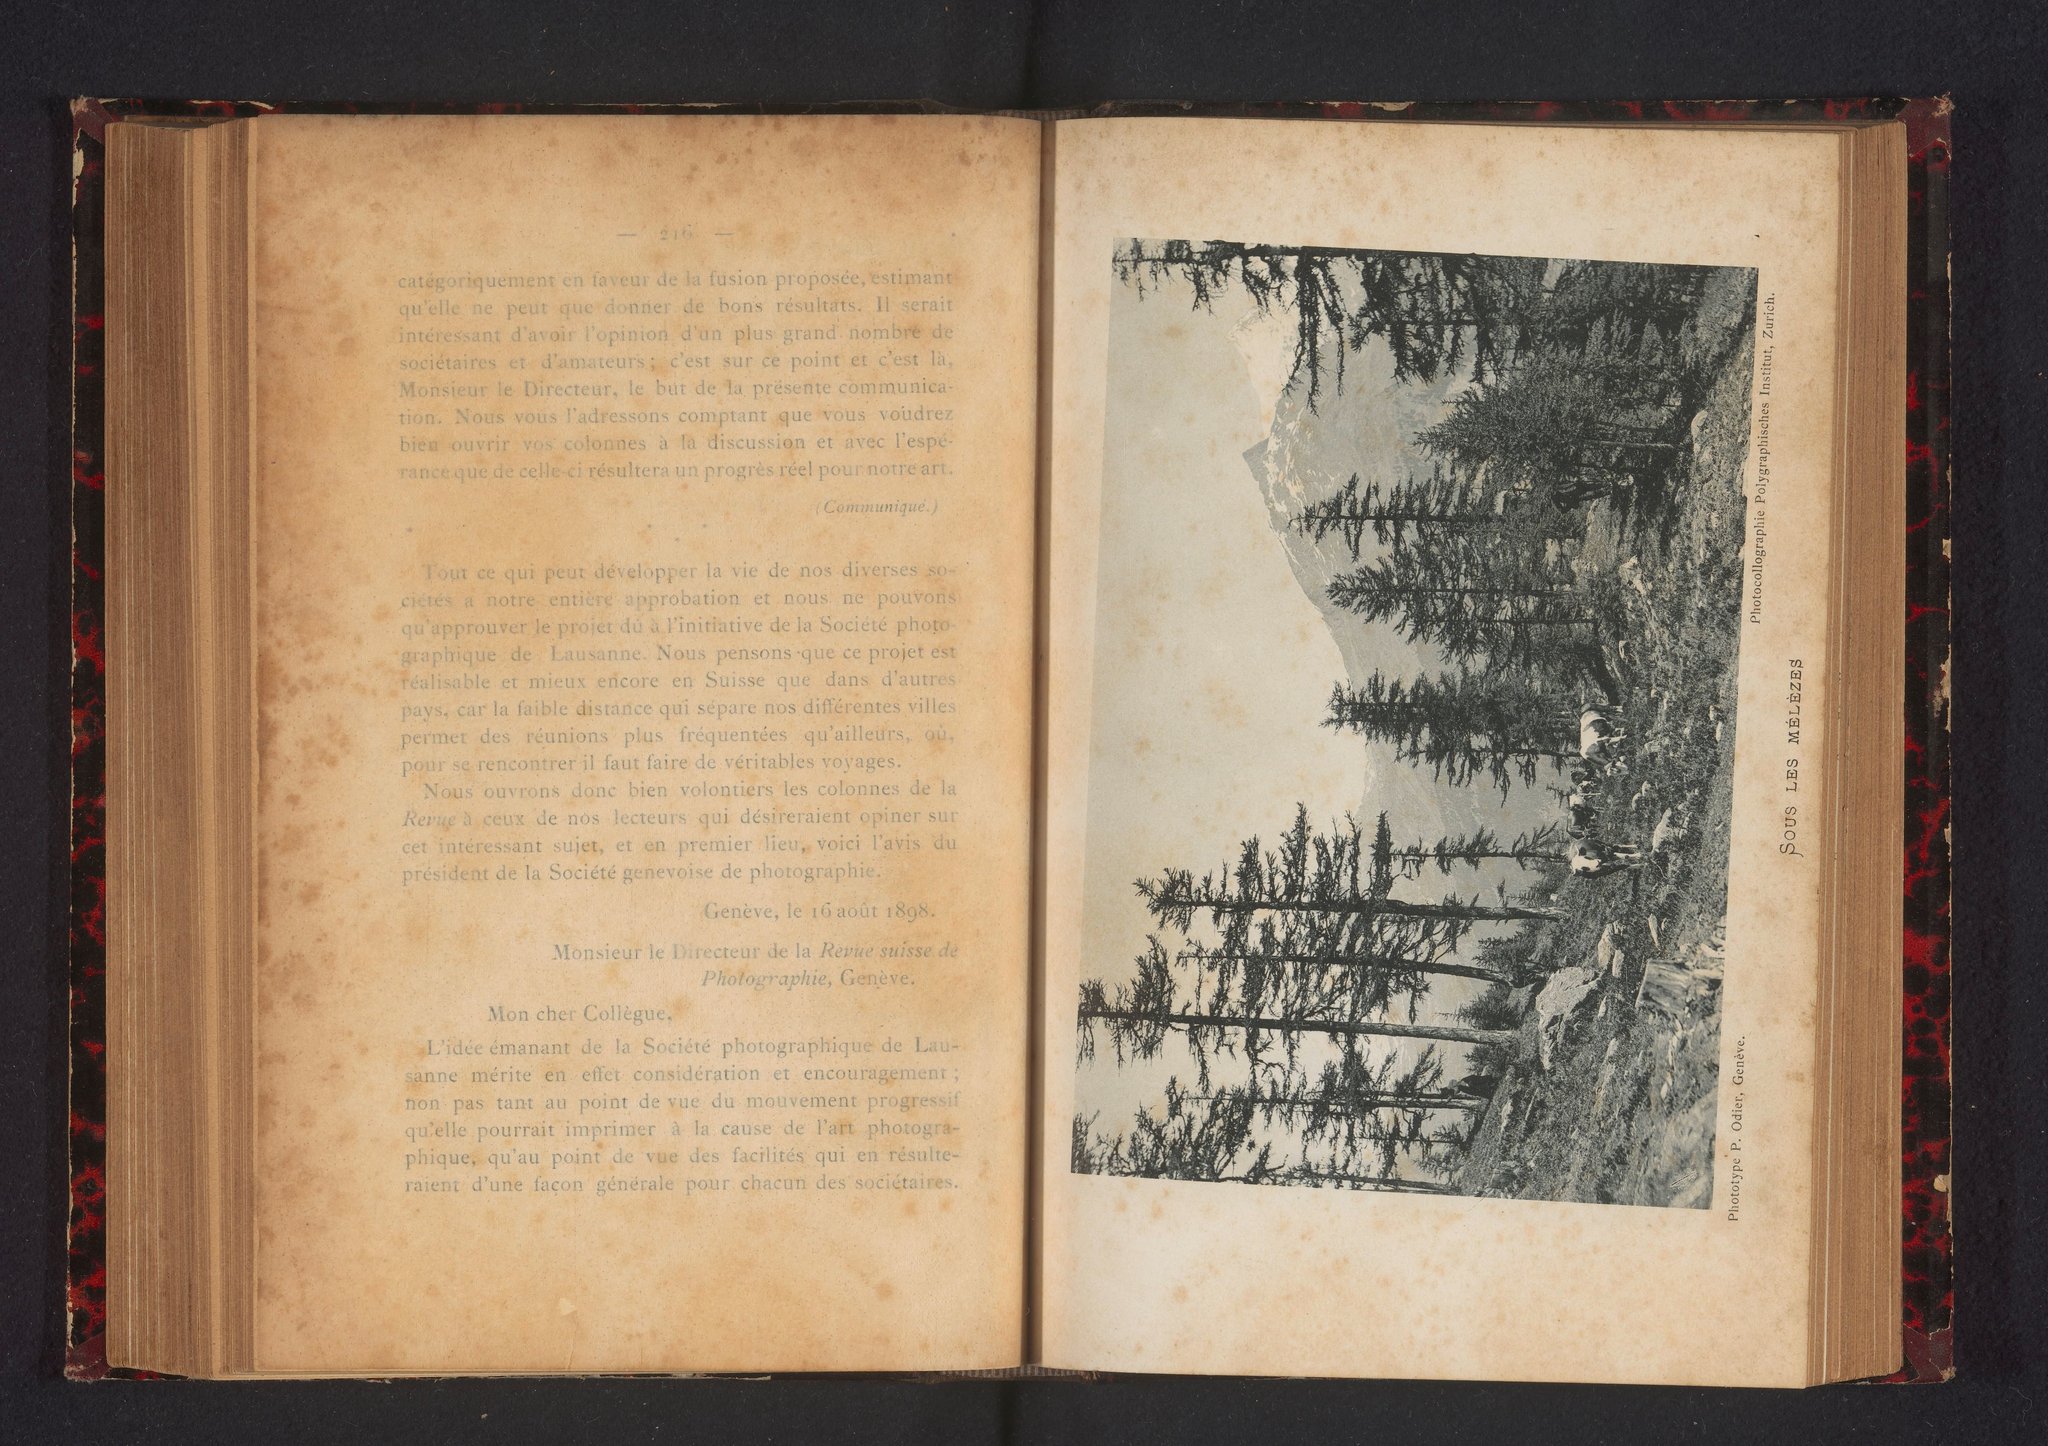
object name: page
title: Gezicht open berglandschap met lariksen en koeien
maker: p. odier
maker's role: fotograaf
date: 1893-1898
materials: paper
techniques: photograph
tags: cow, trees: larch, mountains